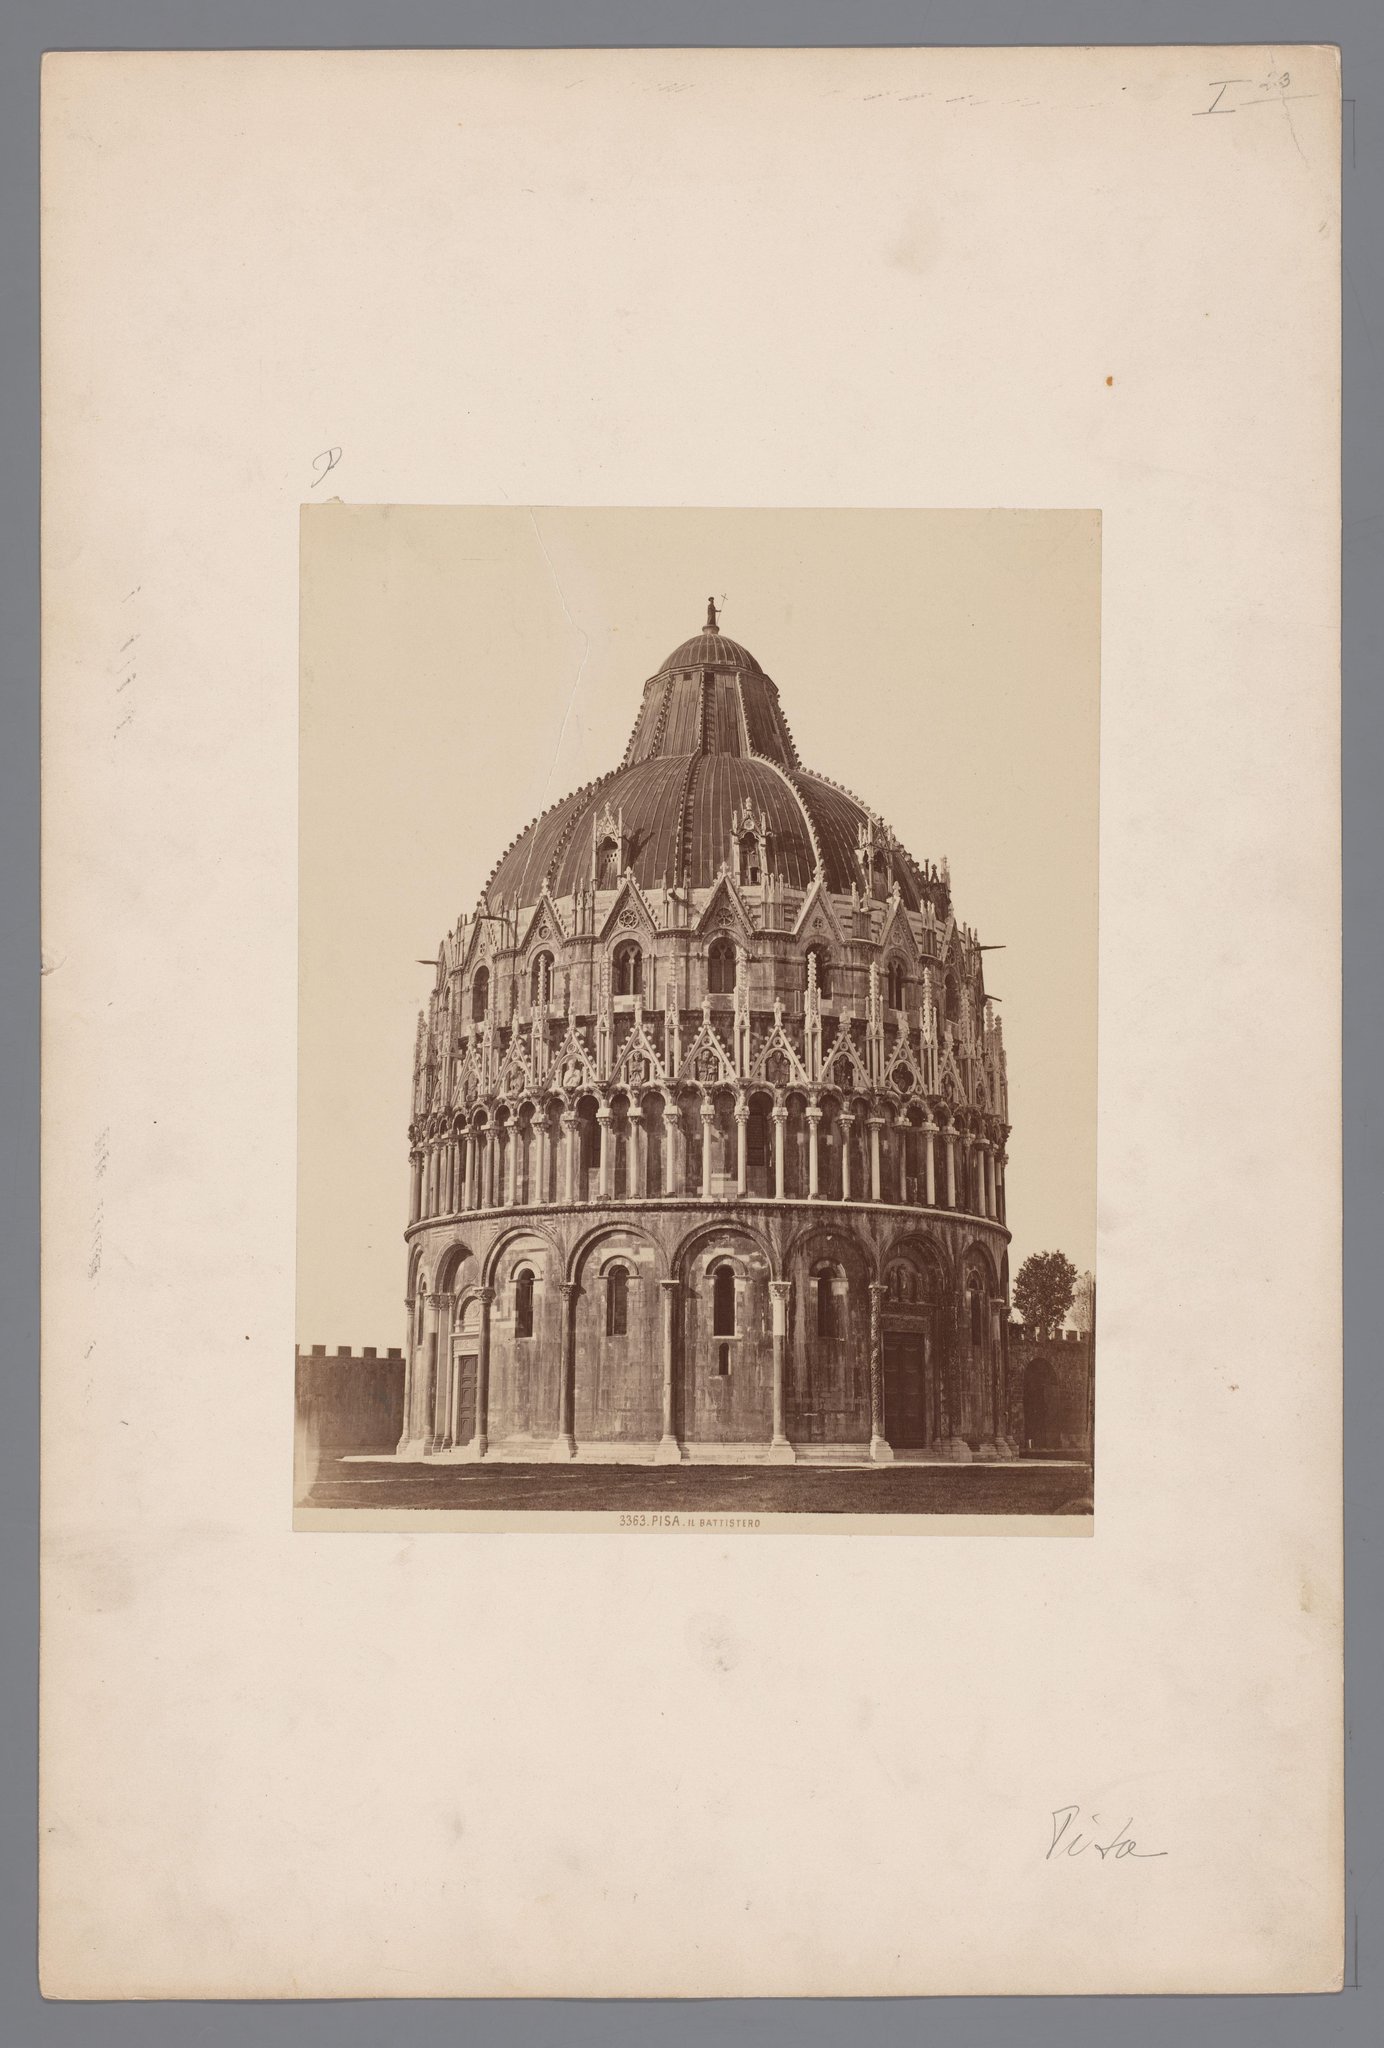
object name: photograph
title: Exterieur van het Baptisterium te Pisa, Italië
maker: Anonymous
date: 1851-1900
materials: cardboard, paper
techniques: albumen print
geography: pisa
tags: baptism, christening ceremony ~ the first of the seven sacraments, church (exterior)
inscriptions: inscription: ‘P’, number: ‘3363.’, inscription: ‘Pisa’, inscription: ‘RSK N 1’, collector's mark: ‘RIJKS SCHOOL VOOR KUNSTNIJVERHEID/ GROEP’, inscription: ‘I 23’